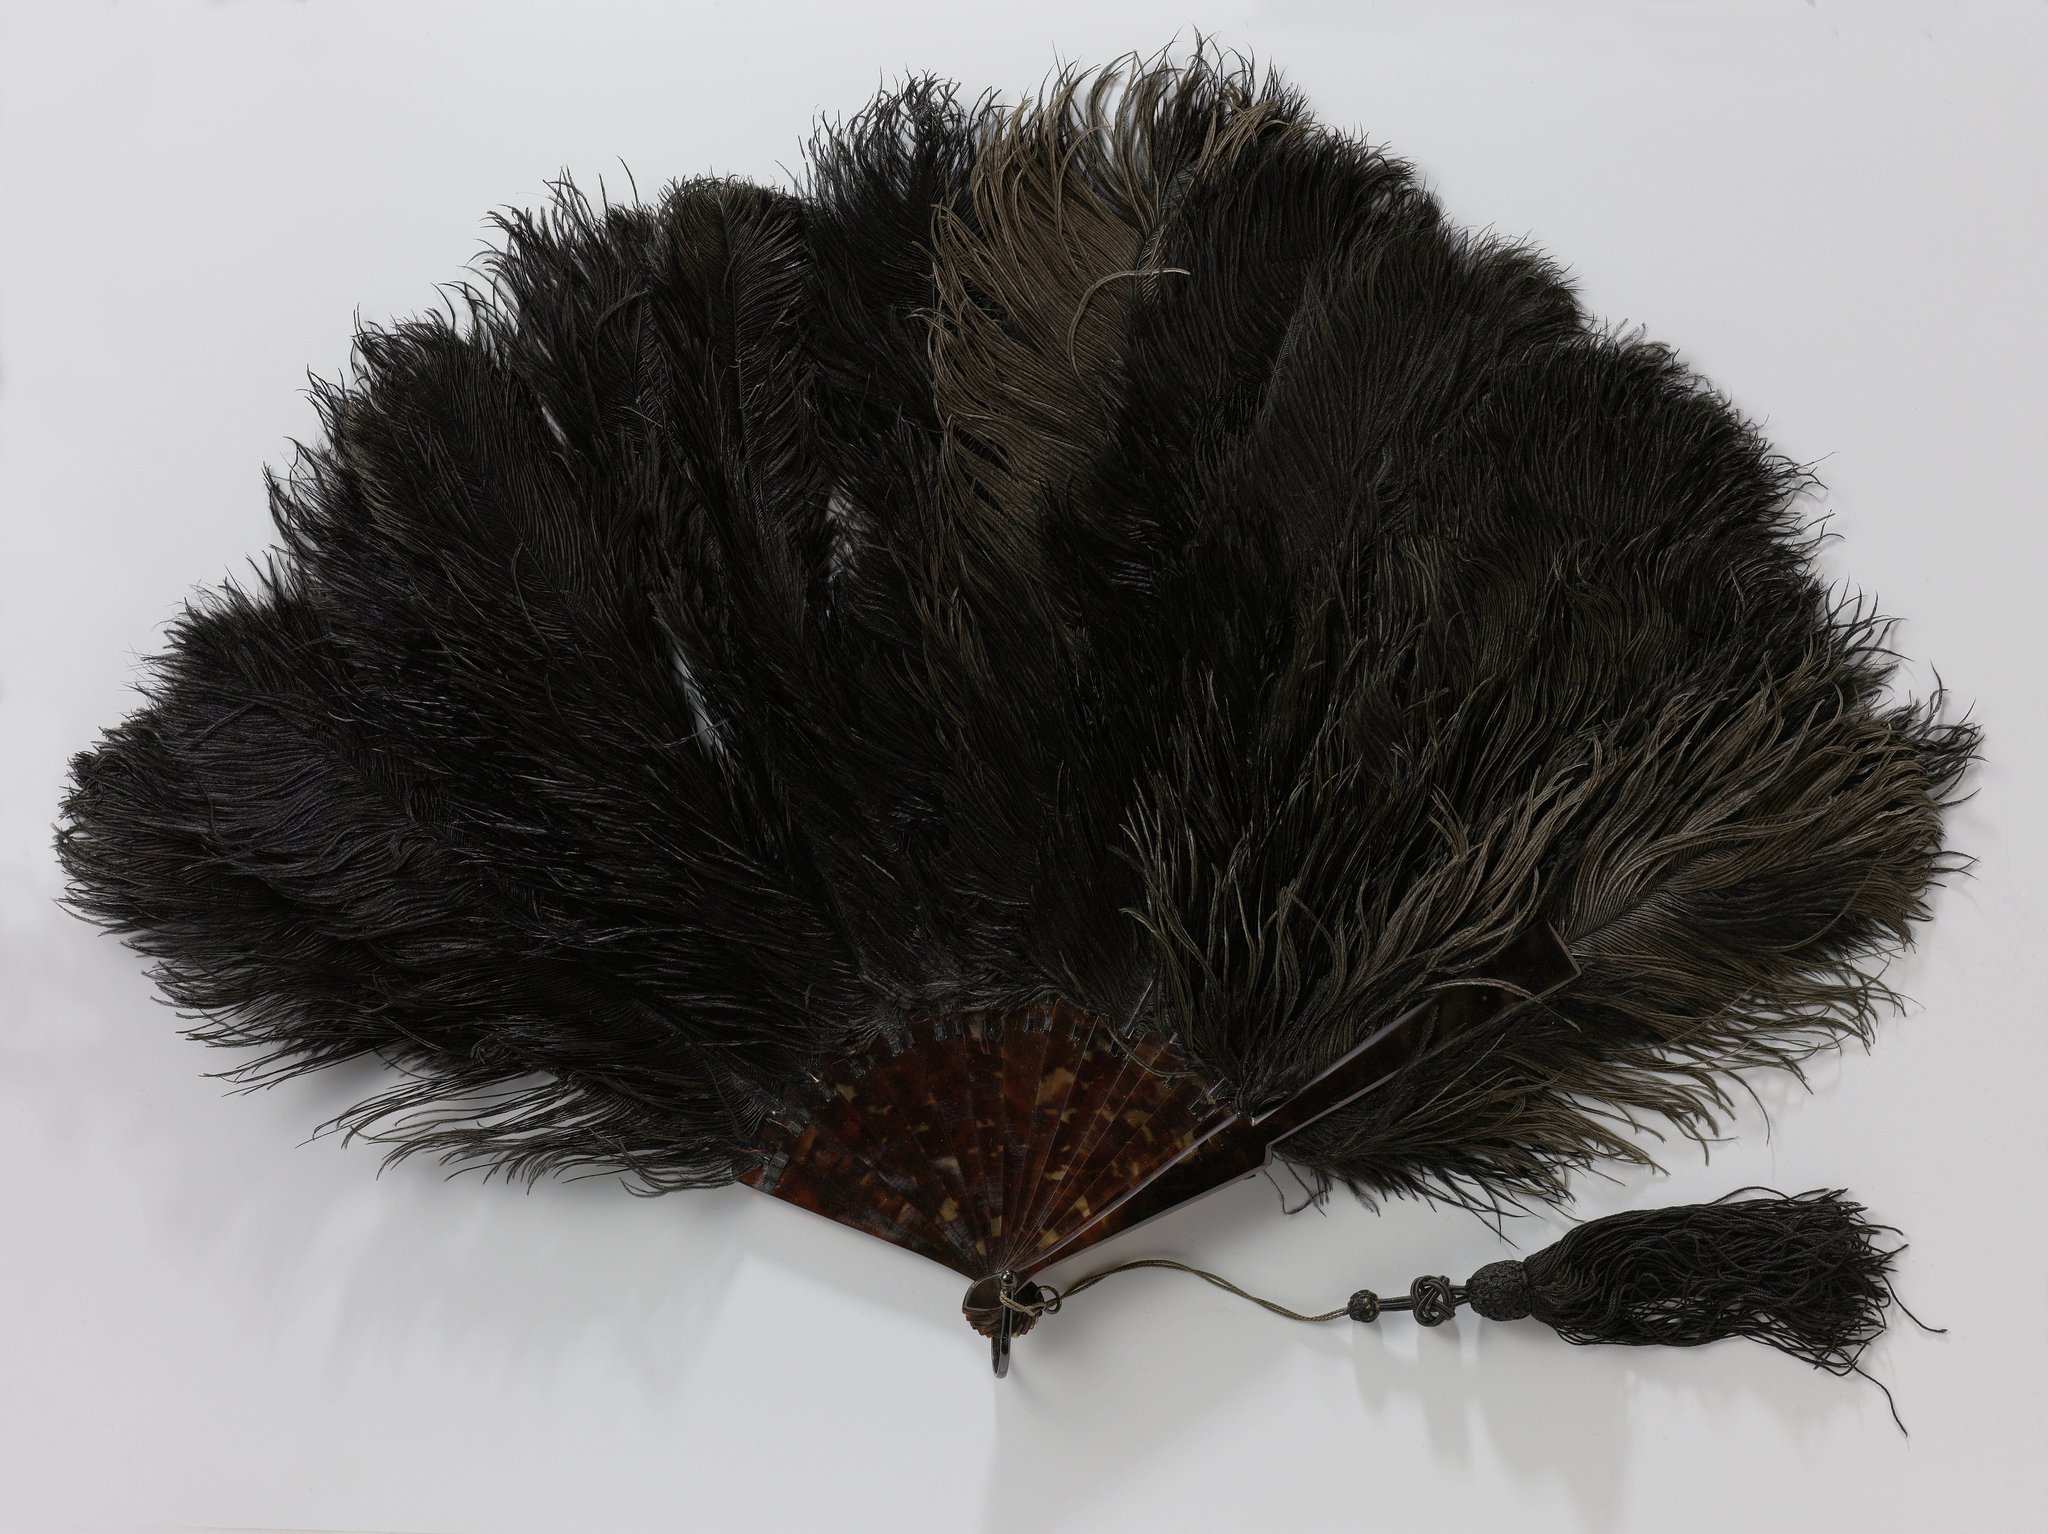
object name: vouwwaaier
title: Vouwwaaier van zwarte struisvogelveren op montuur van onversierd schildpad, voorzien van metalen waaierring waaraan zwarte zijden kwast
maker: Anonymous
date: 1905-1915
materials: metal, textile, silk, shell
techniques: cutting, knotting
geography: netherlands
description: Waaier met montuur van onversierd schildpad waarop zwarte struisveren gemonteerd, voorzien van metalen waaierring waaraan zwarte zijden kwast. 16 Aaneengesloten benen, samengehouden door zwart satijnen lint